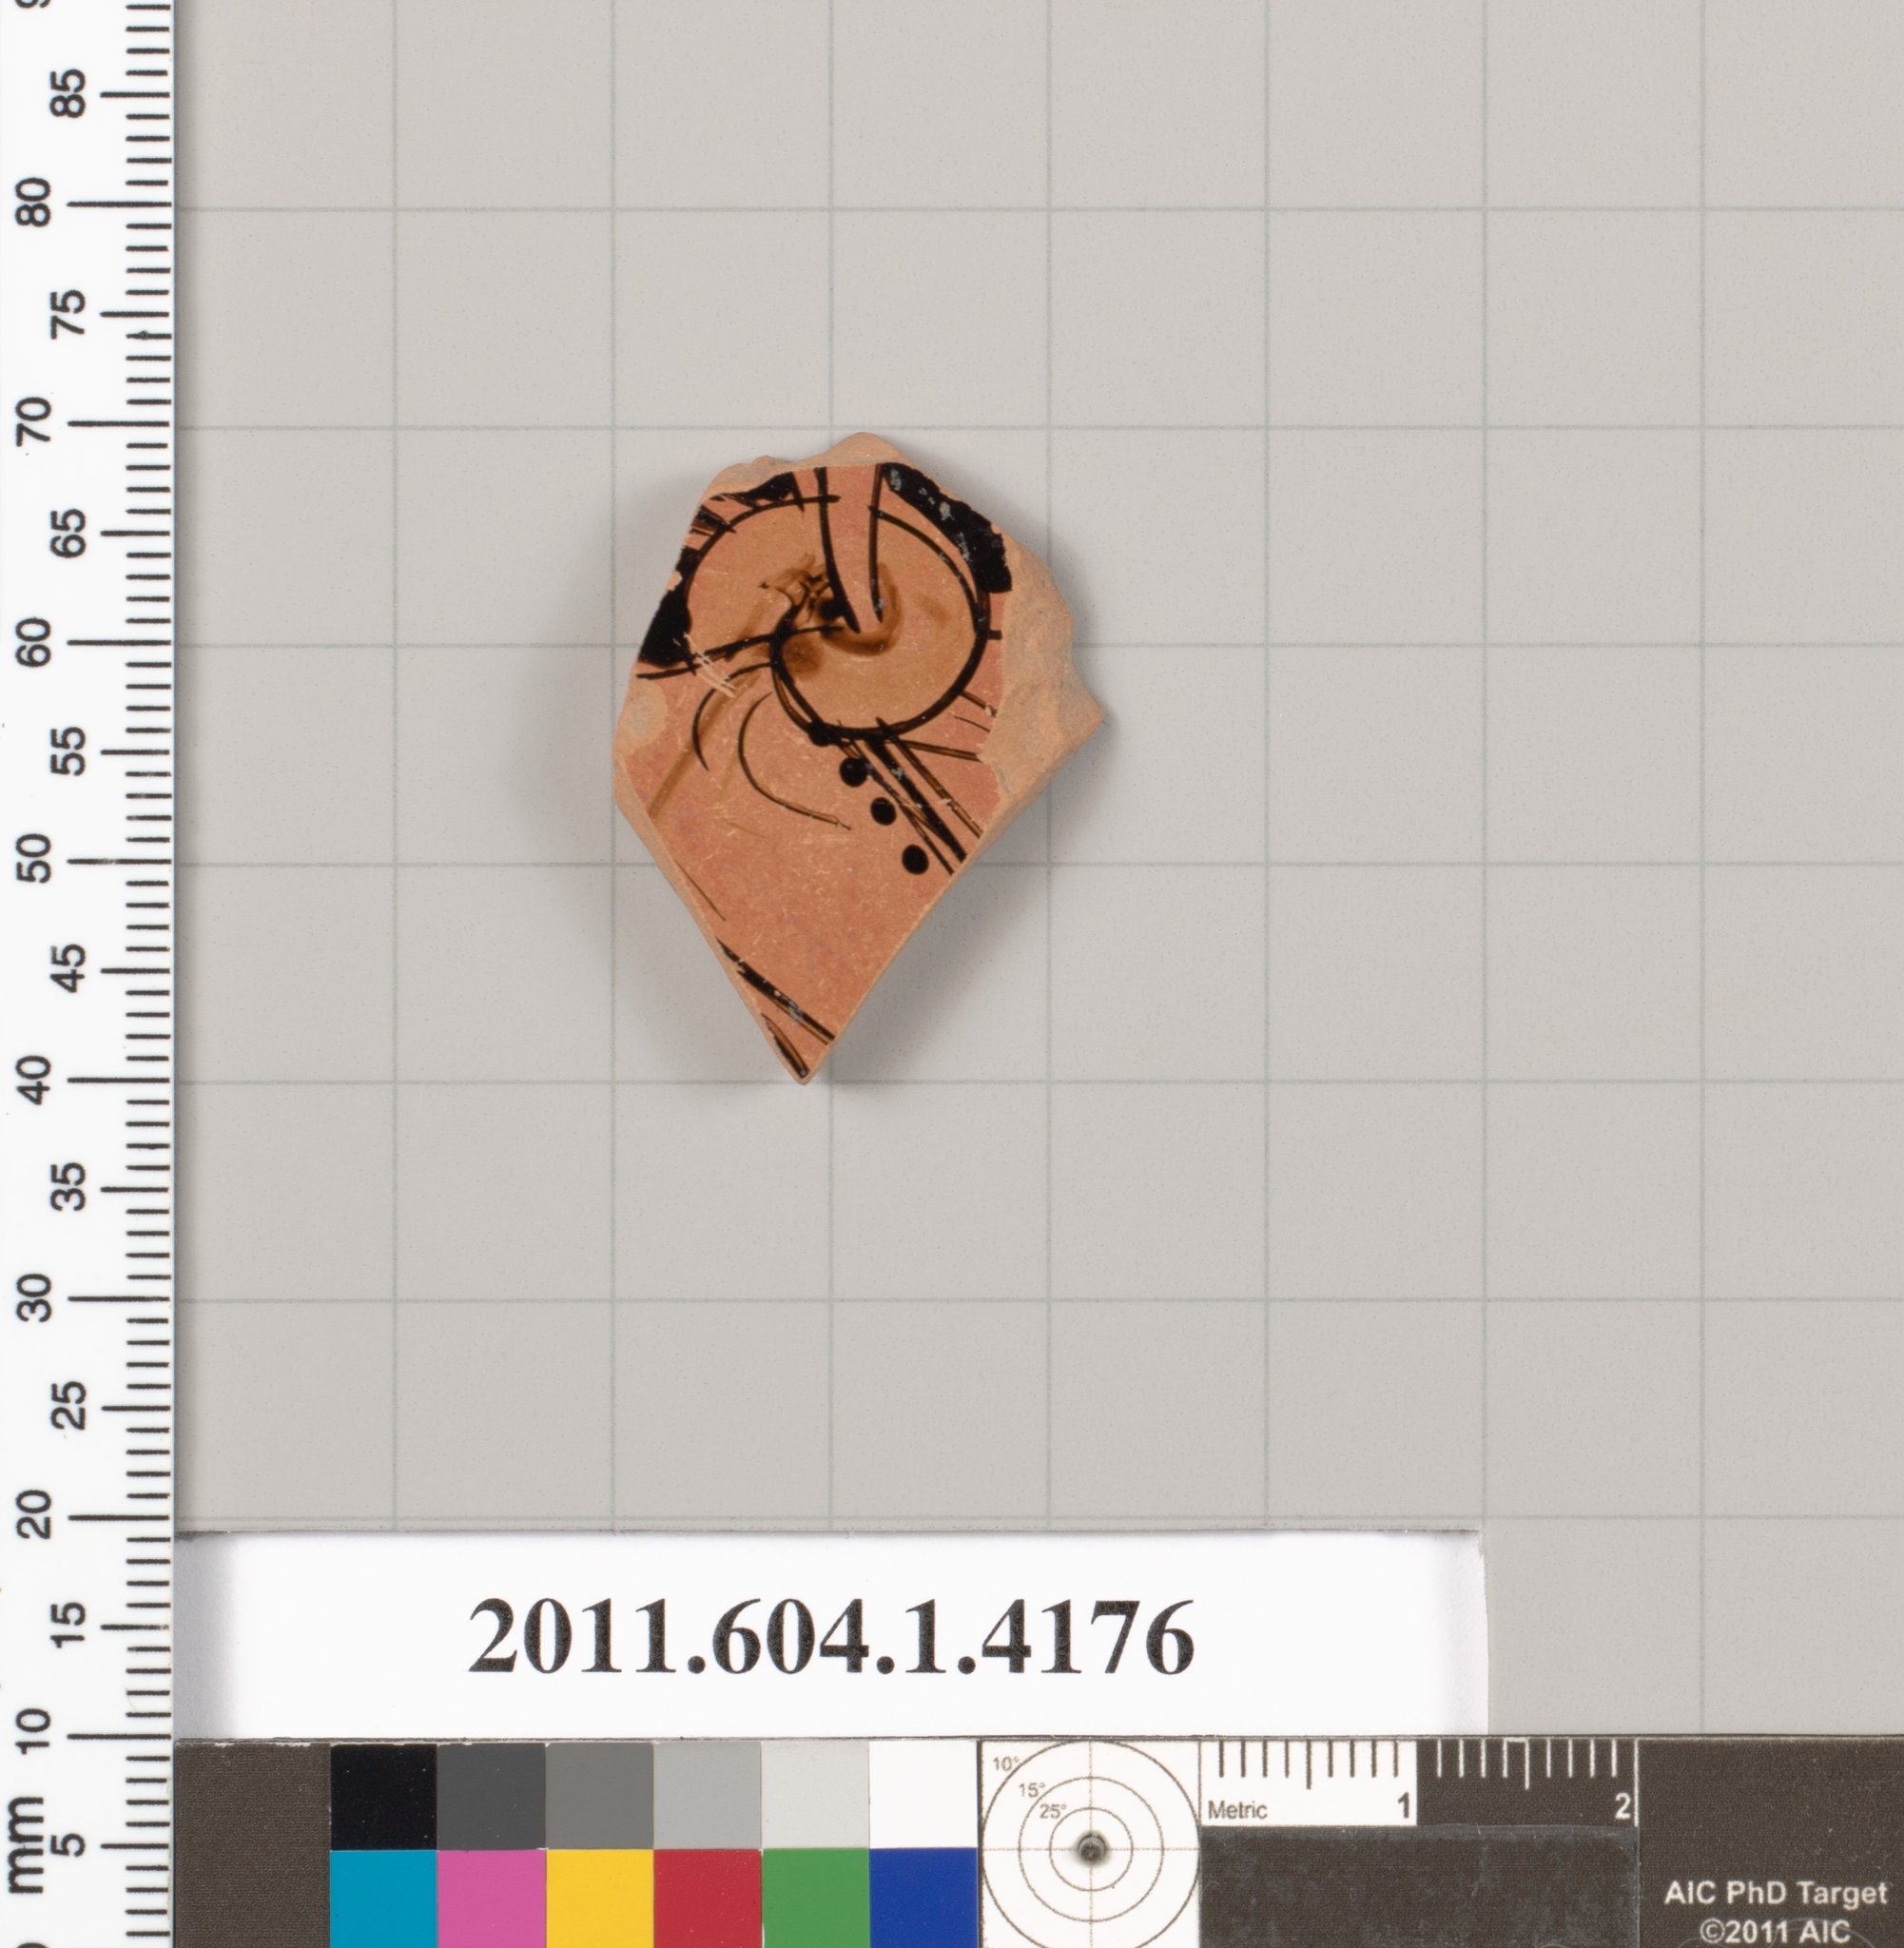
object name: kylix fragment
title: Terracotta fragment of a kylix (drinking cup)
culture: greek, attic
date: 500-480 BCE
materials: terracotta